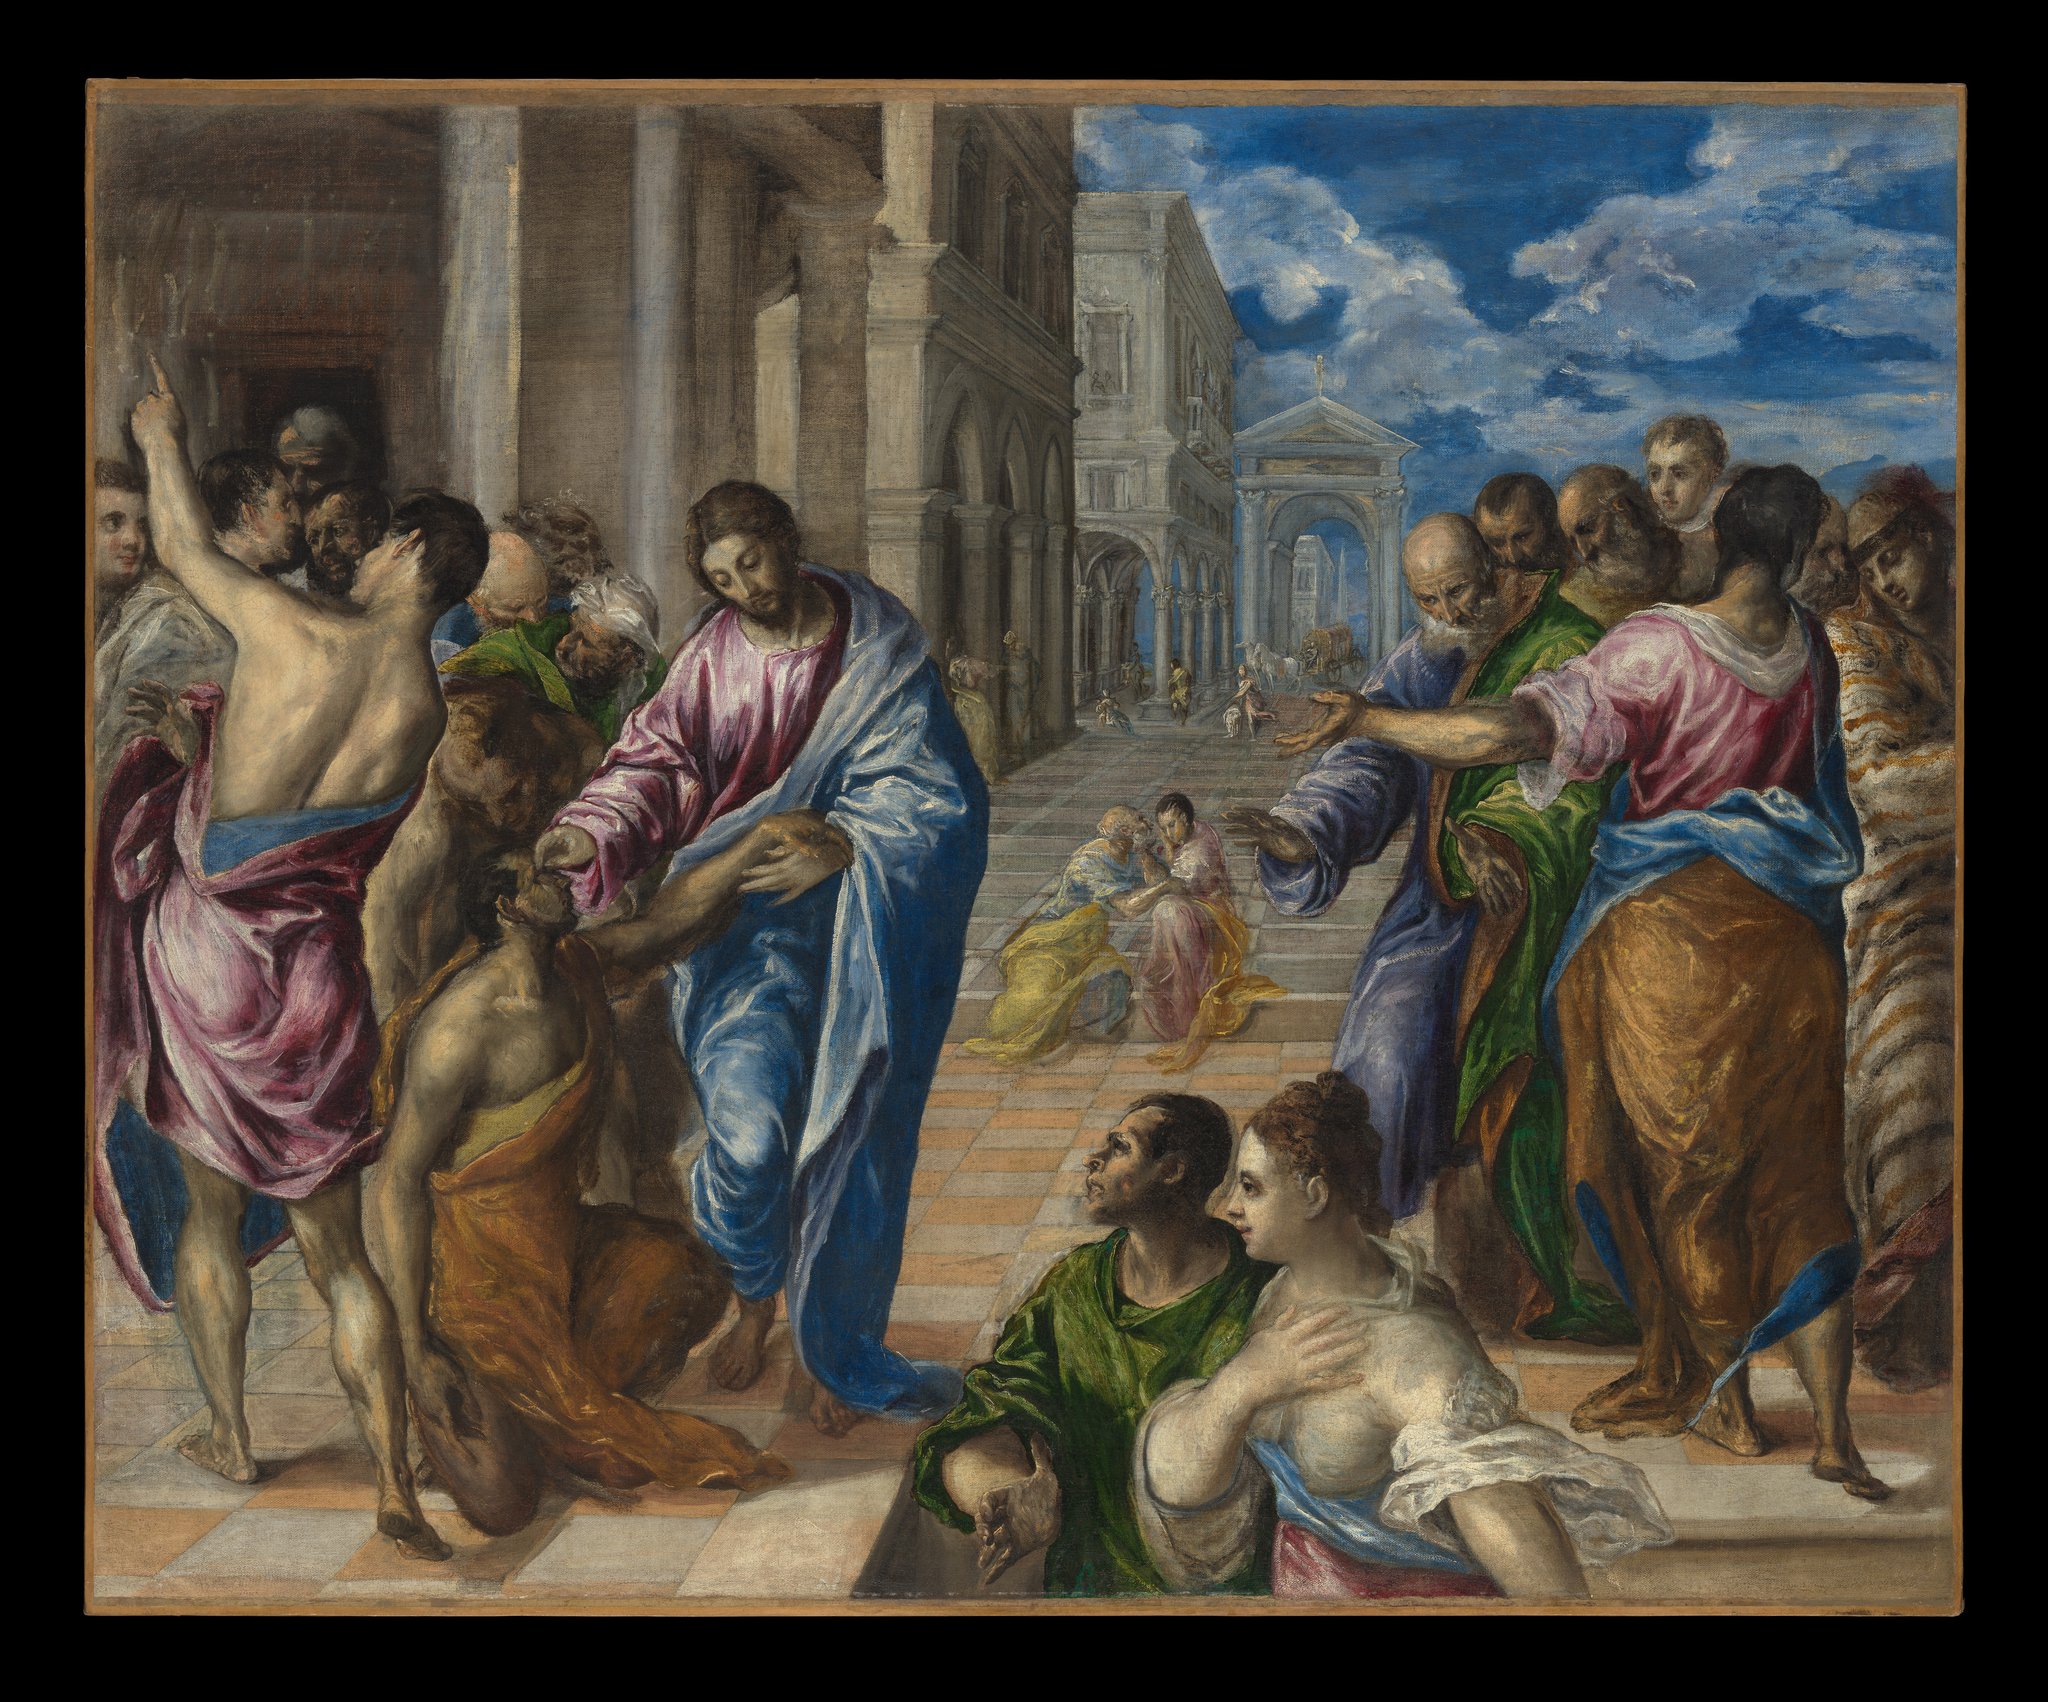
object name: painting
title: Christ Healing the Blind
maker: el greco (domenikos theotokopoulos)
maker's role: artist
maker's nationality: greek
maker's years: 1540-1614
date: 1570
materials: canvas, oil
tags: men,women,christ